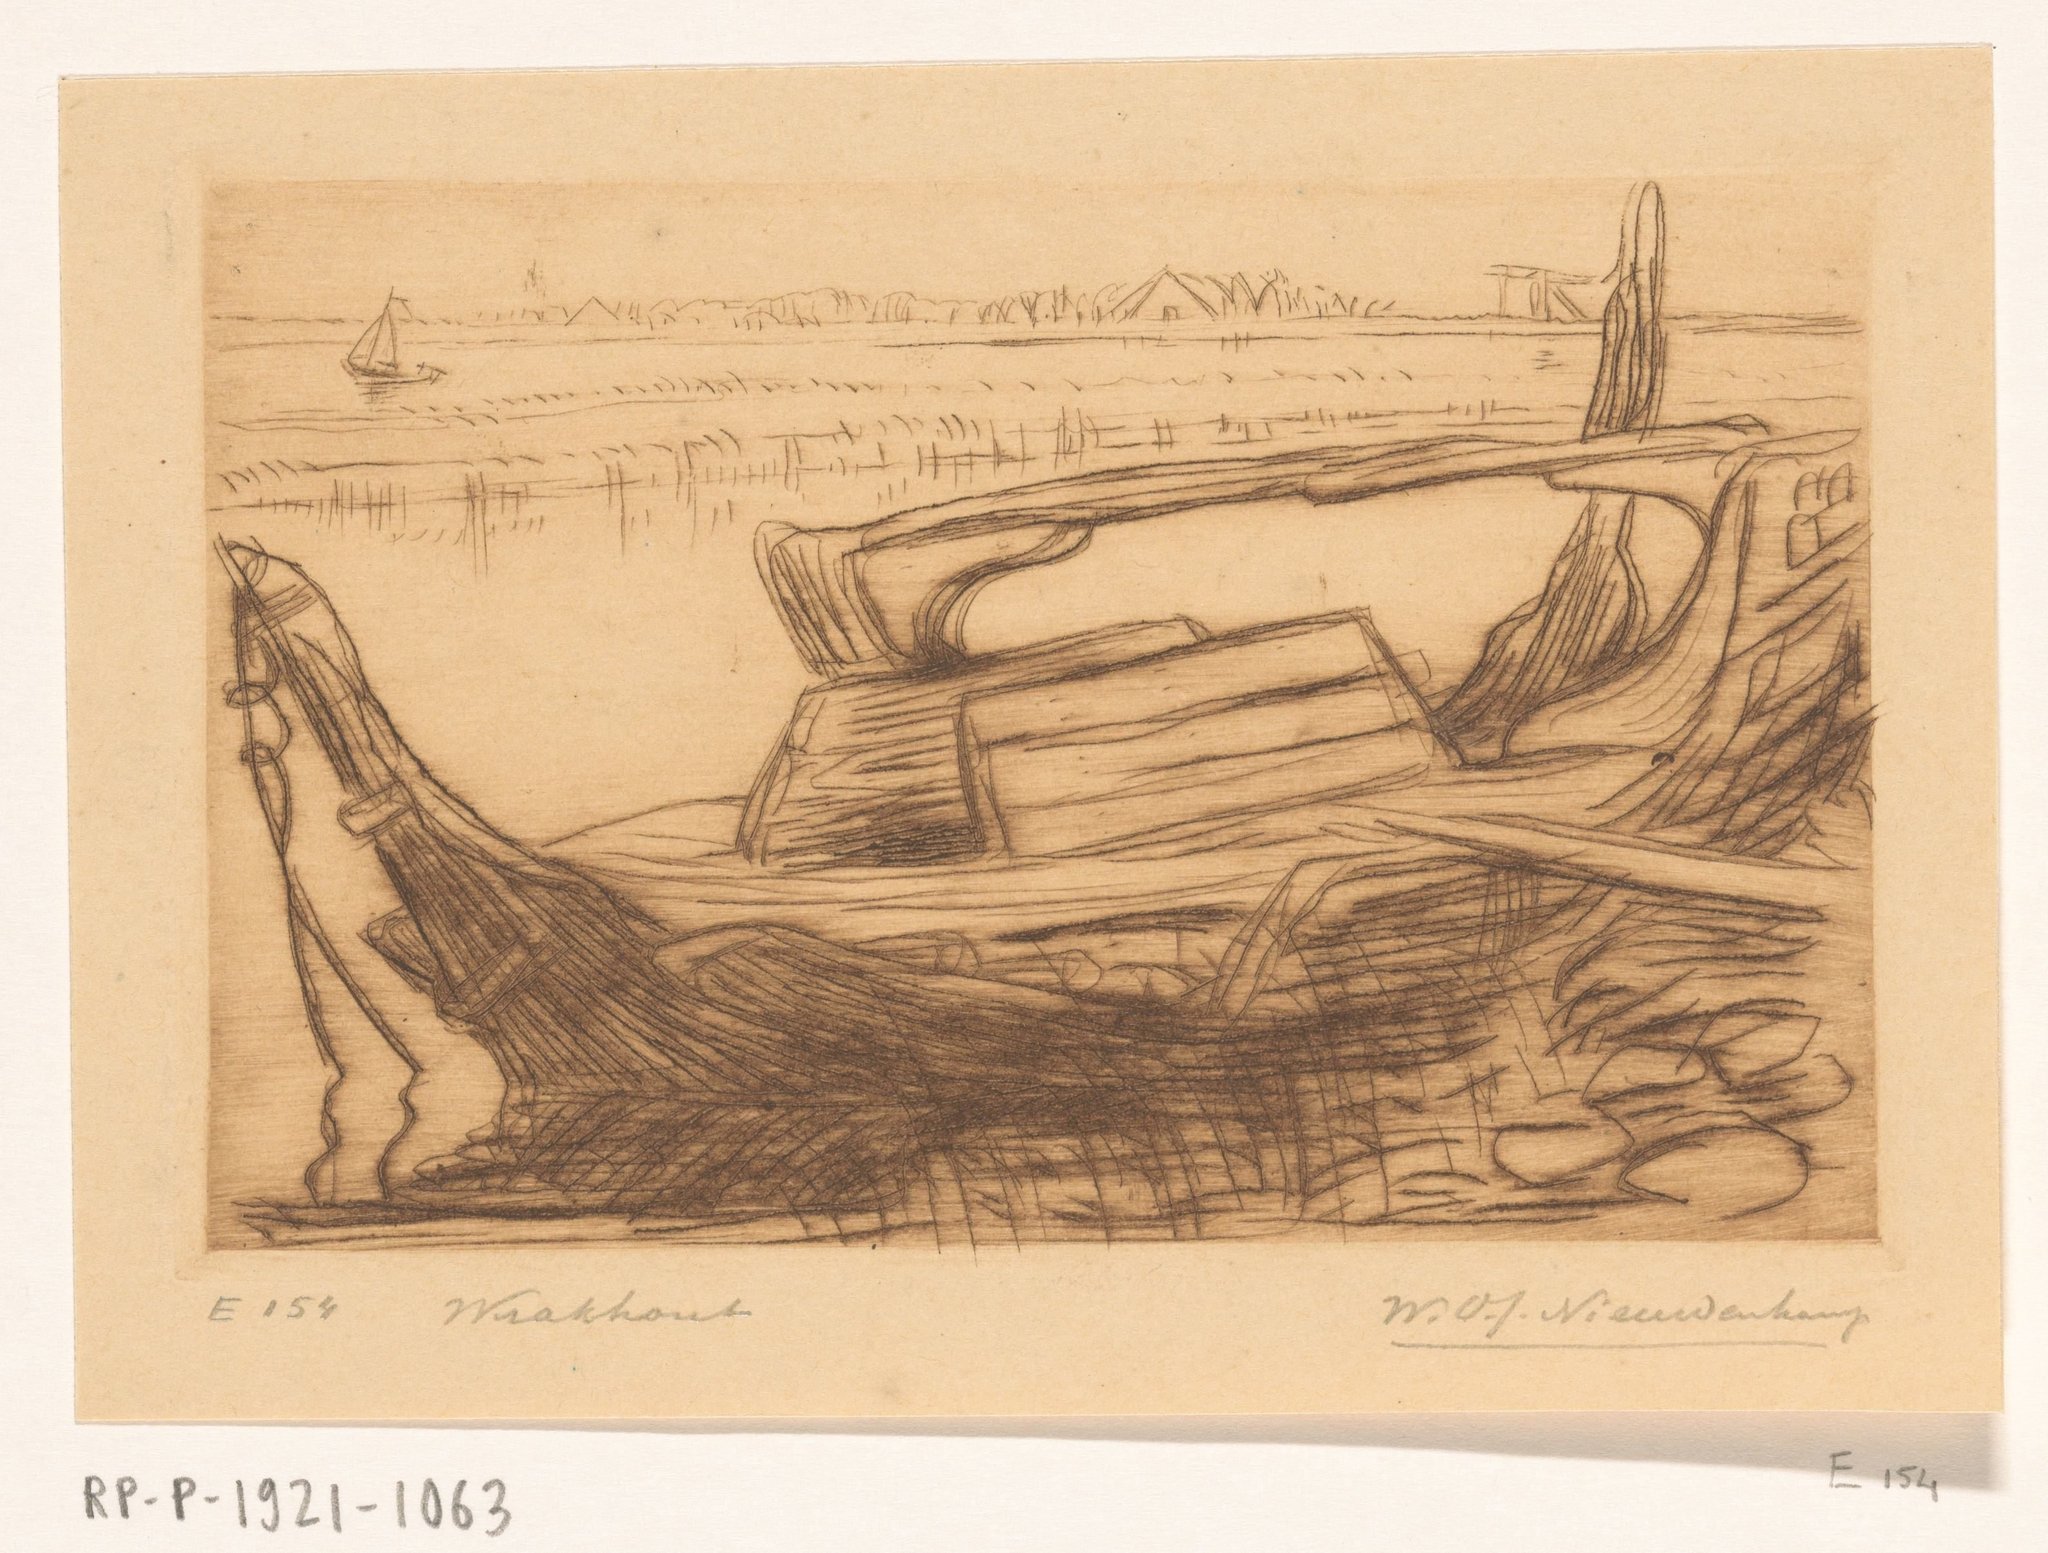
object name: print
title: Wrakhout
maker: wijnand otto jan nieuwenkamp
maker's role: draughtsman, print maker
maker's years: 1874-1950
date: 1914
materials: paper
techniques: drypoint, intaglio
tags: parts of ship's exterior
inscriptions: collector's mark: Lugt 2233